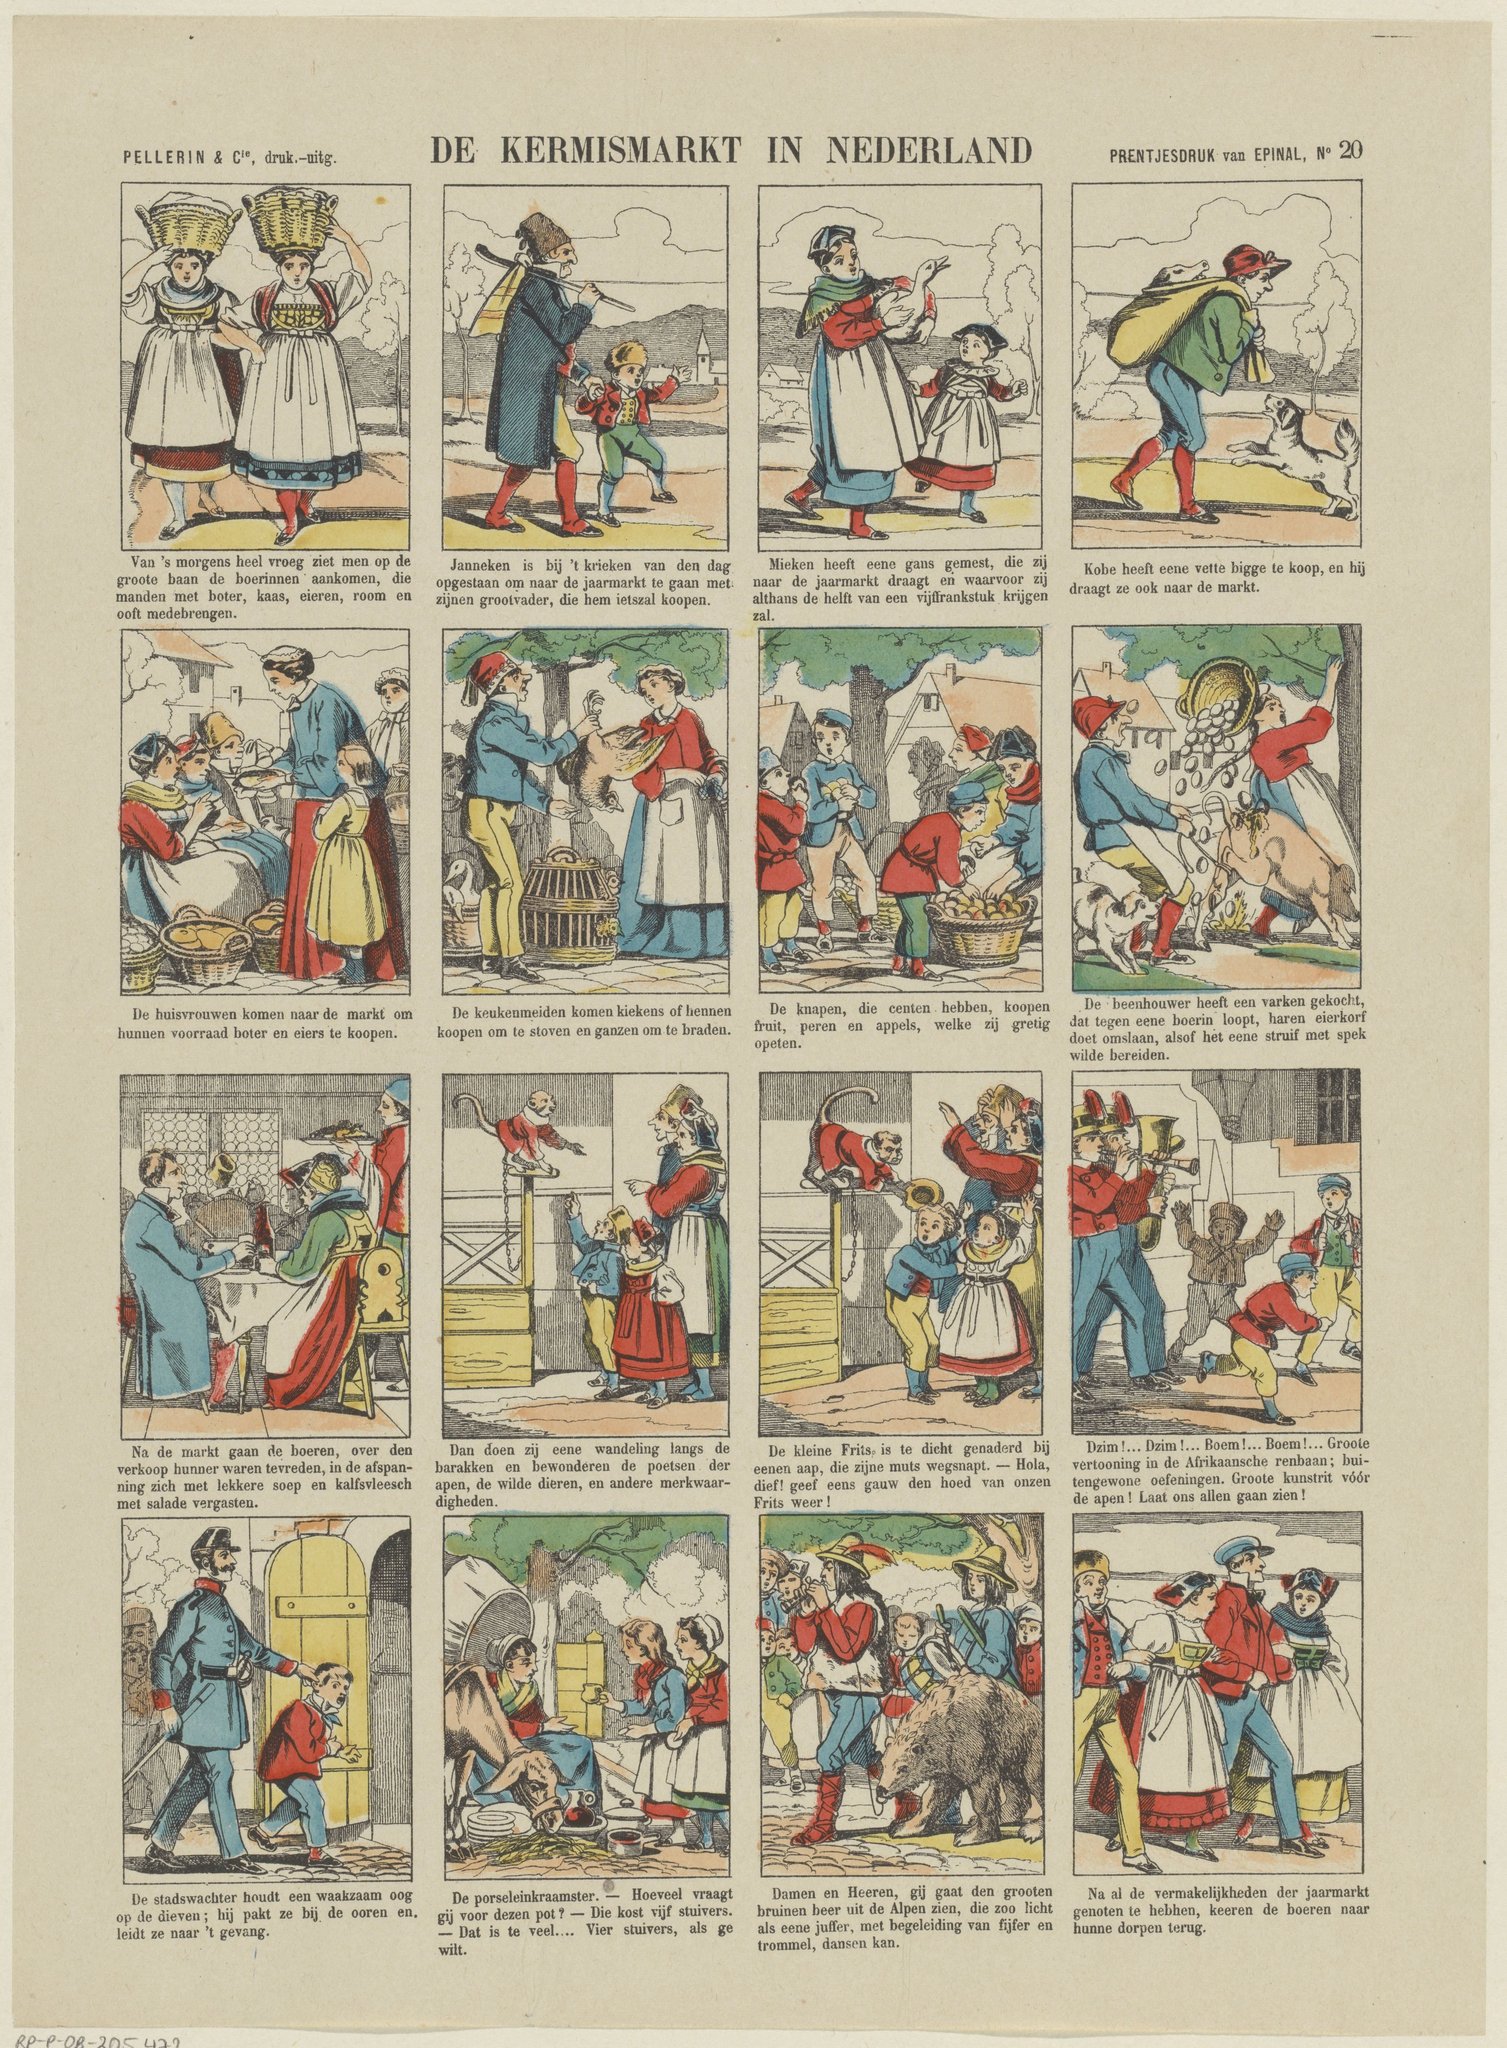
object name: popular print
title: Prentjesdruk van Épinal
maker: Anonymous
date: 1902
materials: paper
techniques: colour, letterpress printing, lithograph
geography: epinal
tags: fancy fair, pleasure fair and circus, market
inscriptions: collector's mark: Lugt 2760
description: Blad met 16 circus- en markttaferelen. Onder elke afbeelding een onderschrift. Genummerd rechtsboven: No 20.